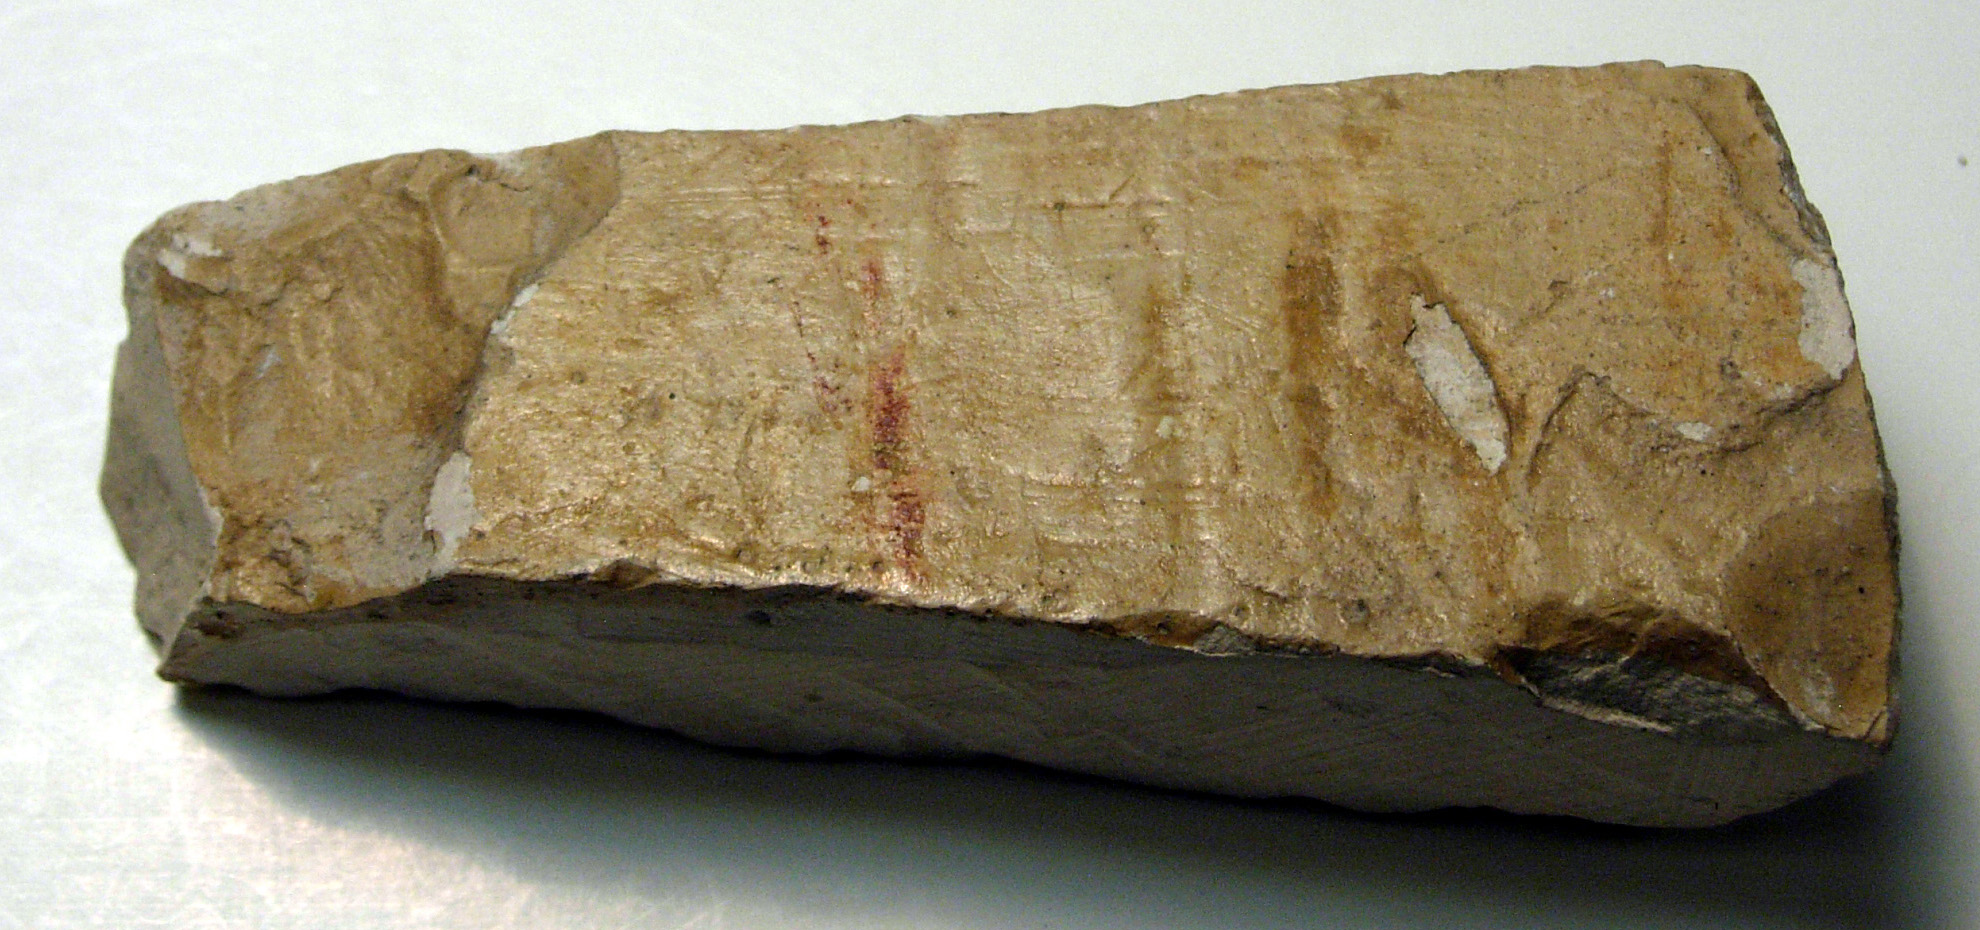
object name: relief, tomb of nespekashuty, wall casing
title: Wall casing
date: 664-610 BCE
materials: limestone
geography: egypt